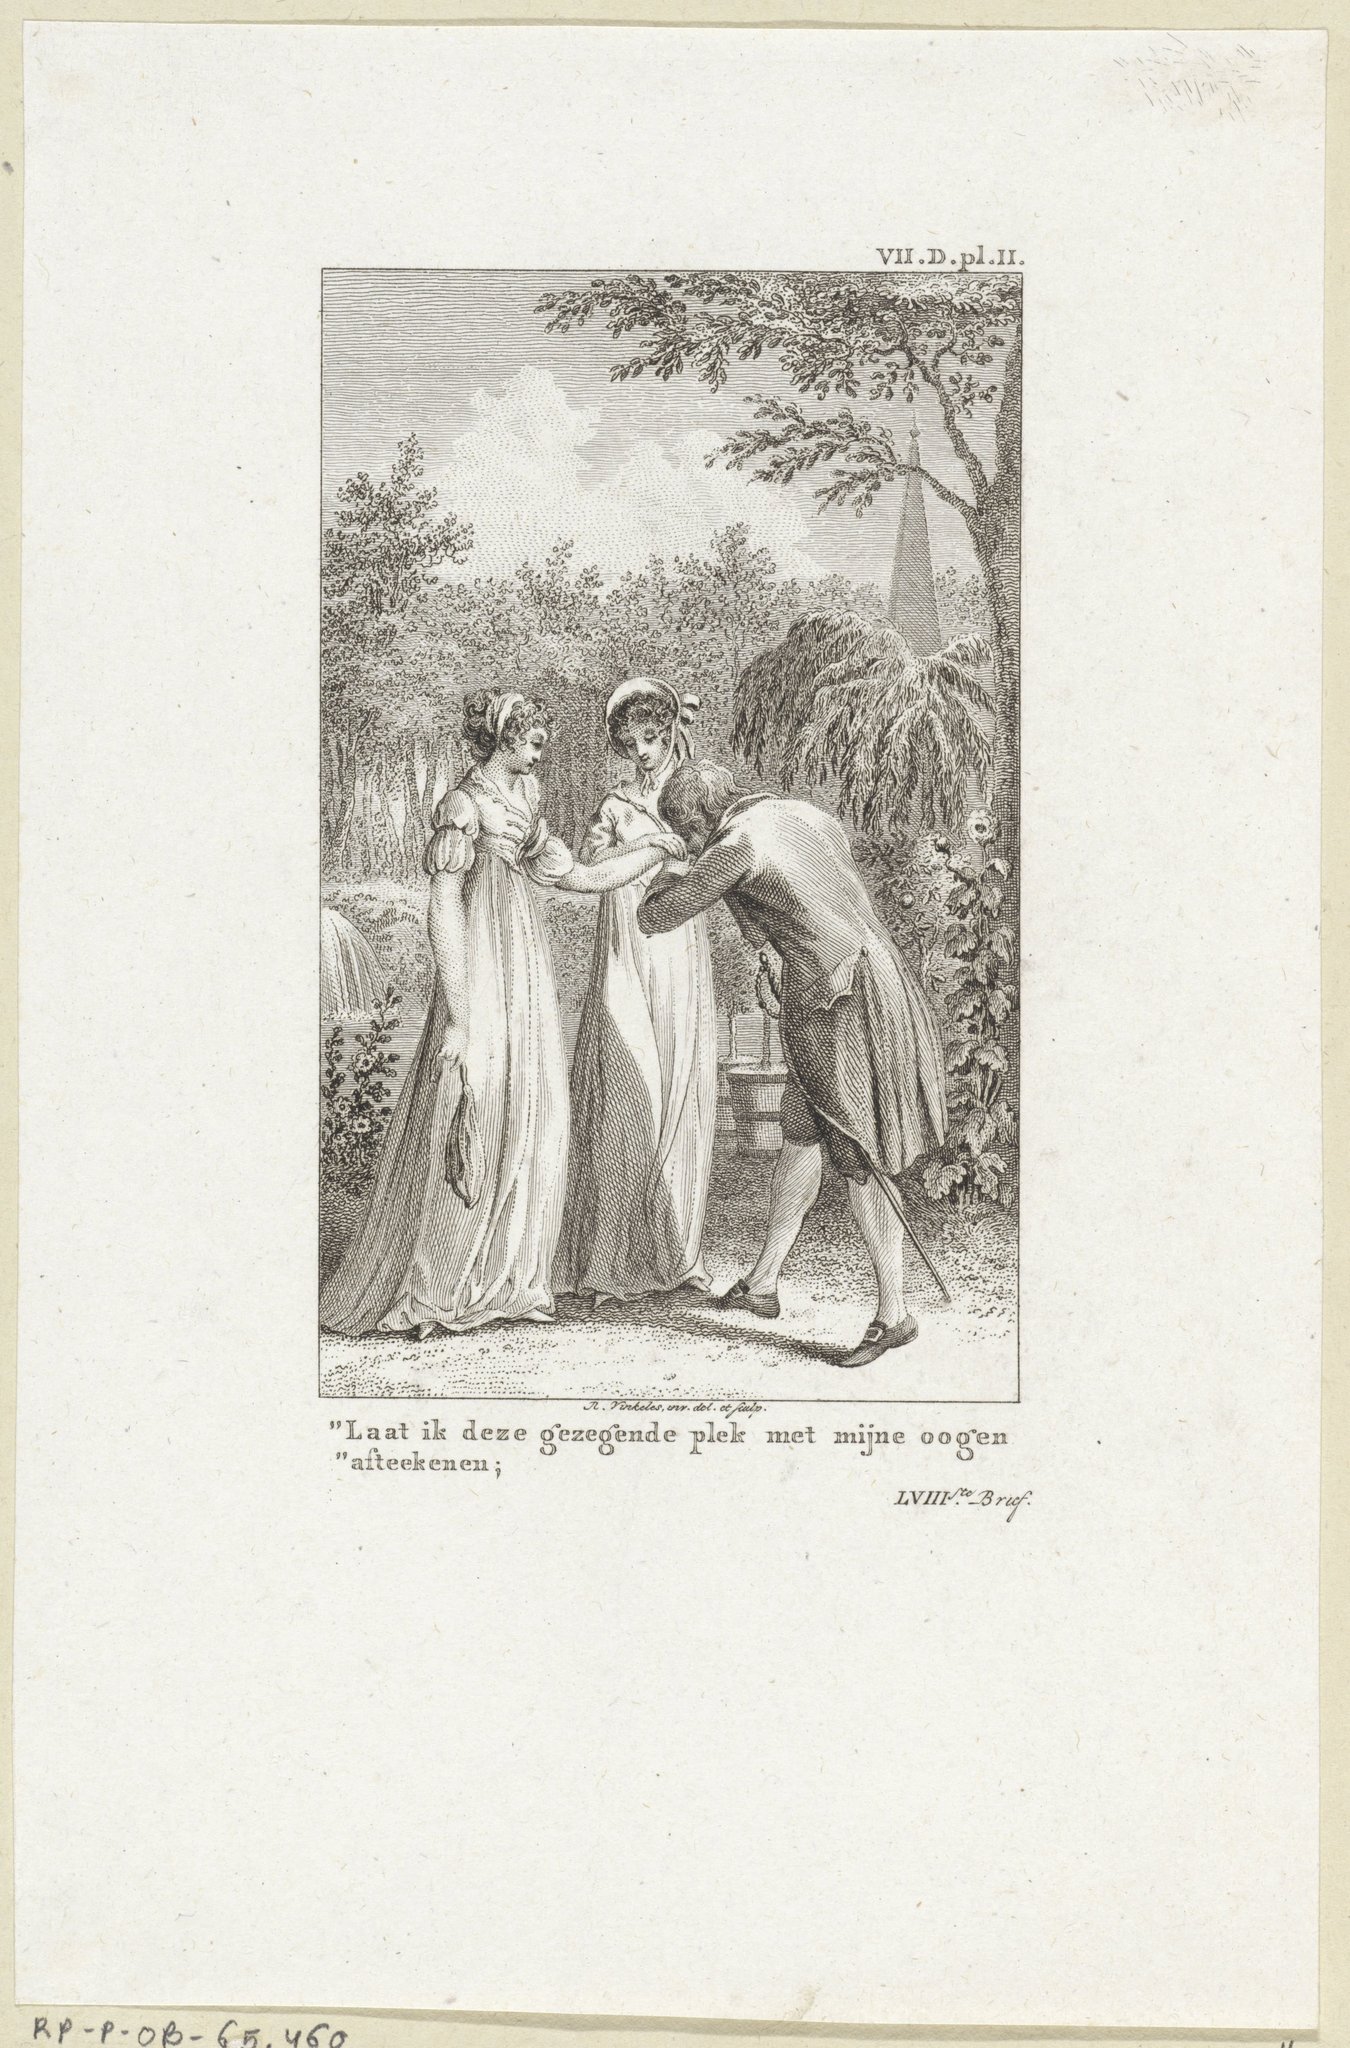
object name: print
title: Laat ik deze gezegende plek met mijne oogen aftekenen;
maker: reinier vinkeles (i)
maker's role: draughtsman, print maker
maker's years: 1741-1816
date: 1751-1816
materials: paper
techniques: engraving, etching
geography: amsterdam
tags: park, kissing the hand (lovers)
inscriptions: collector's mark: Lugt 240